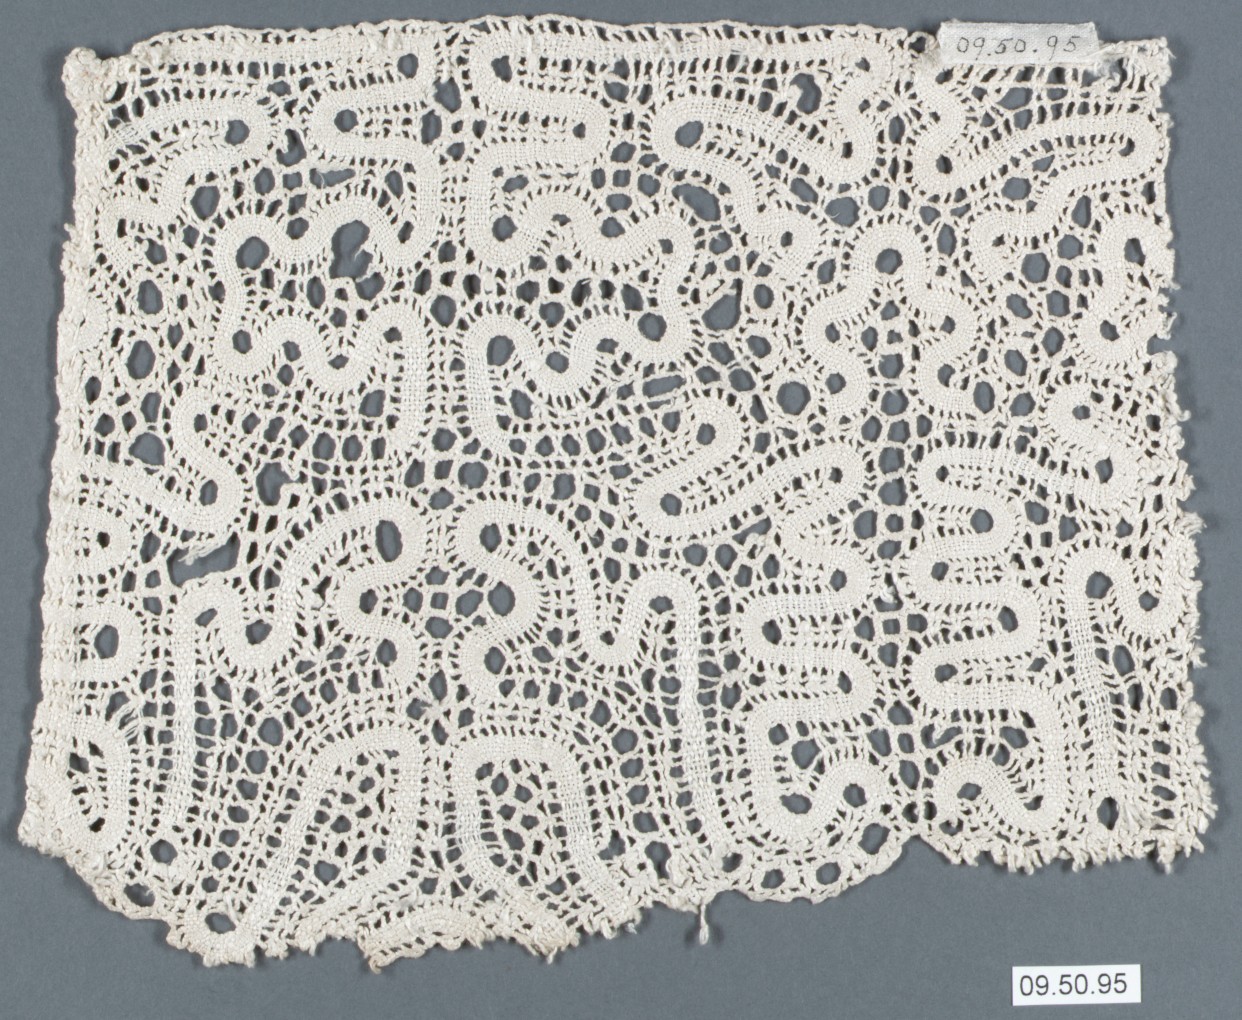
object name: fragment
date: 1701-1800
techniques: lace